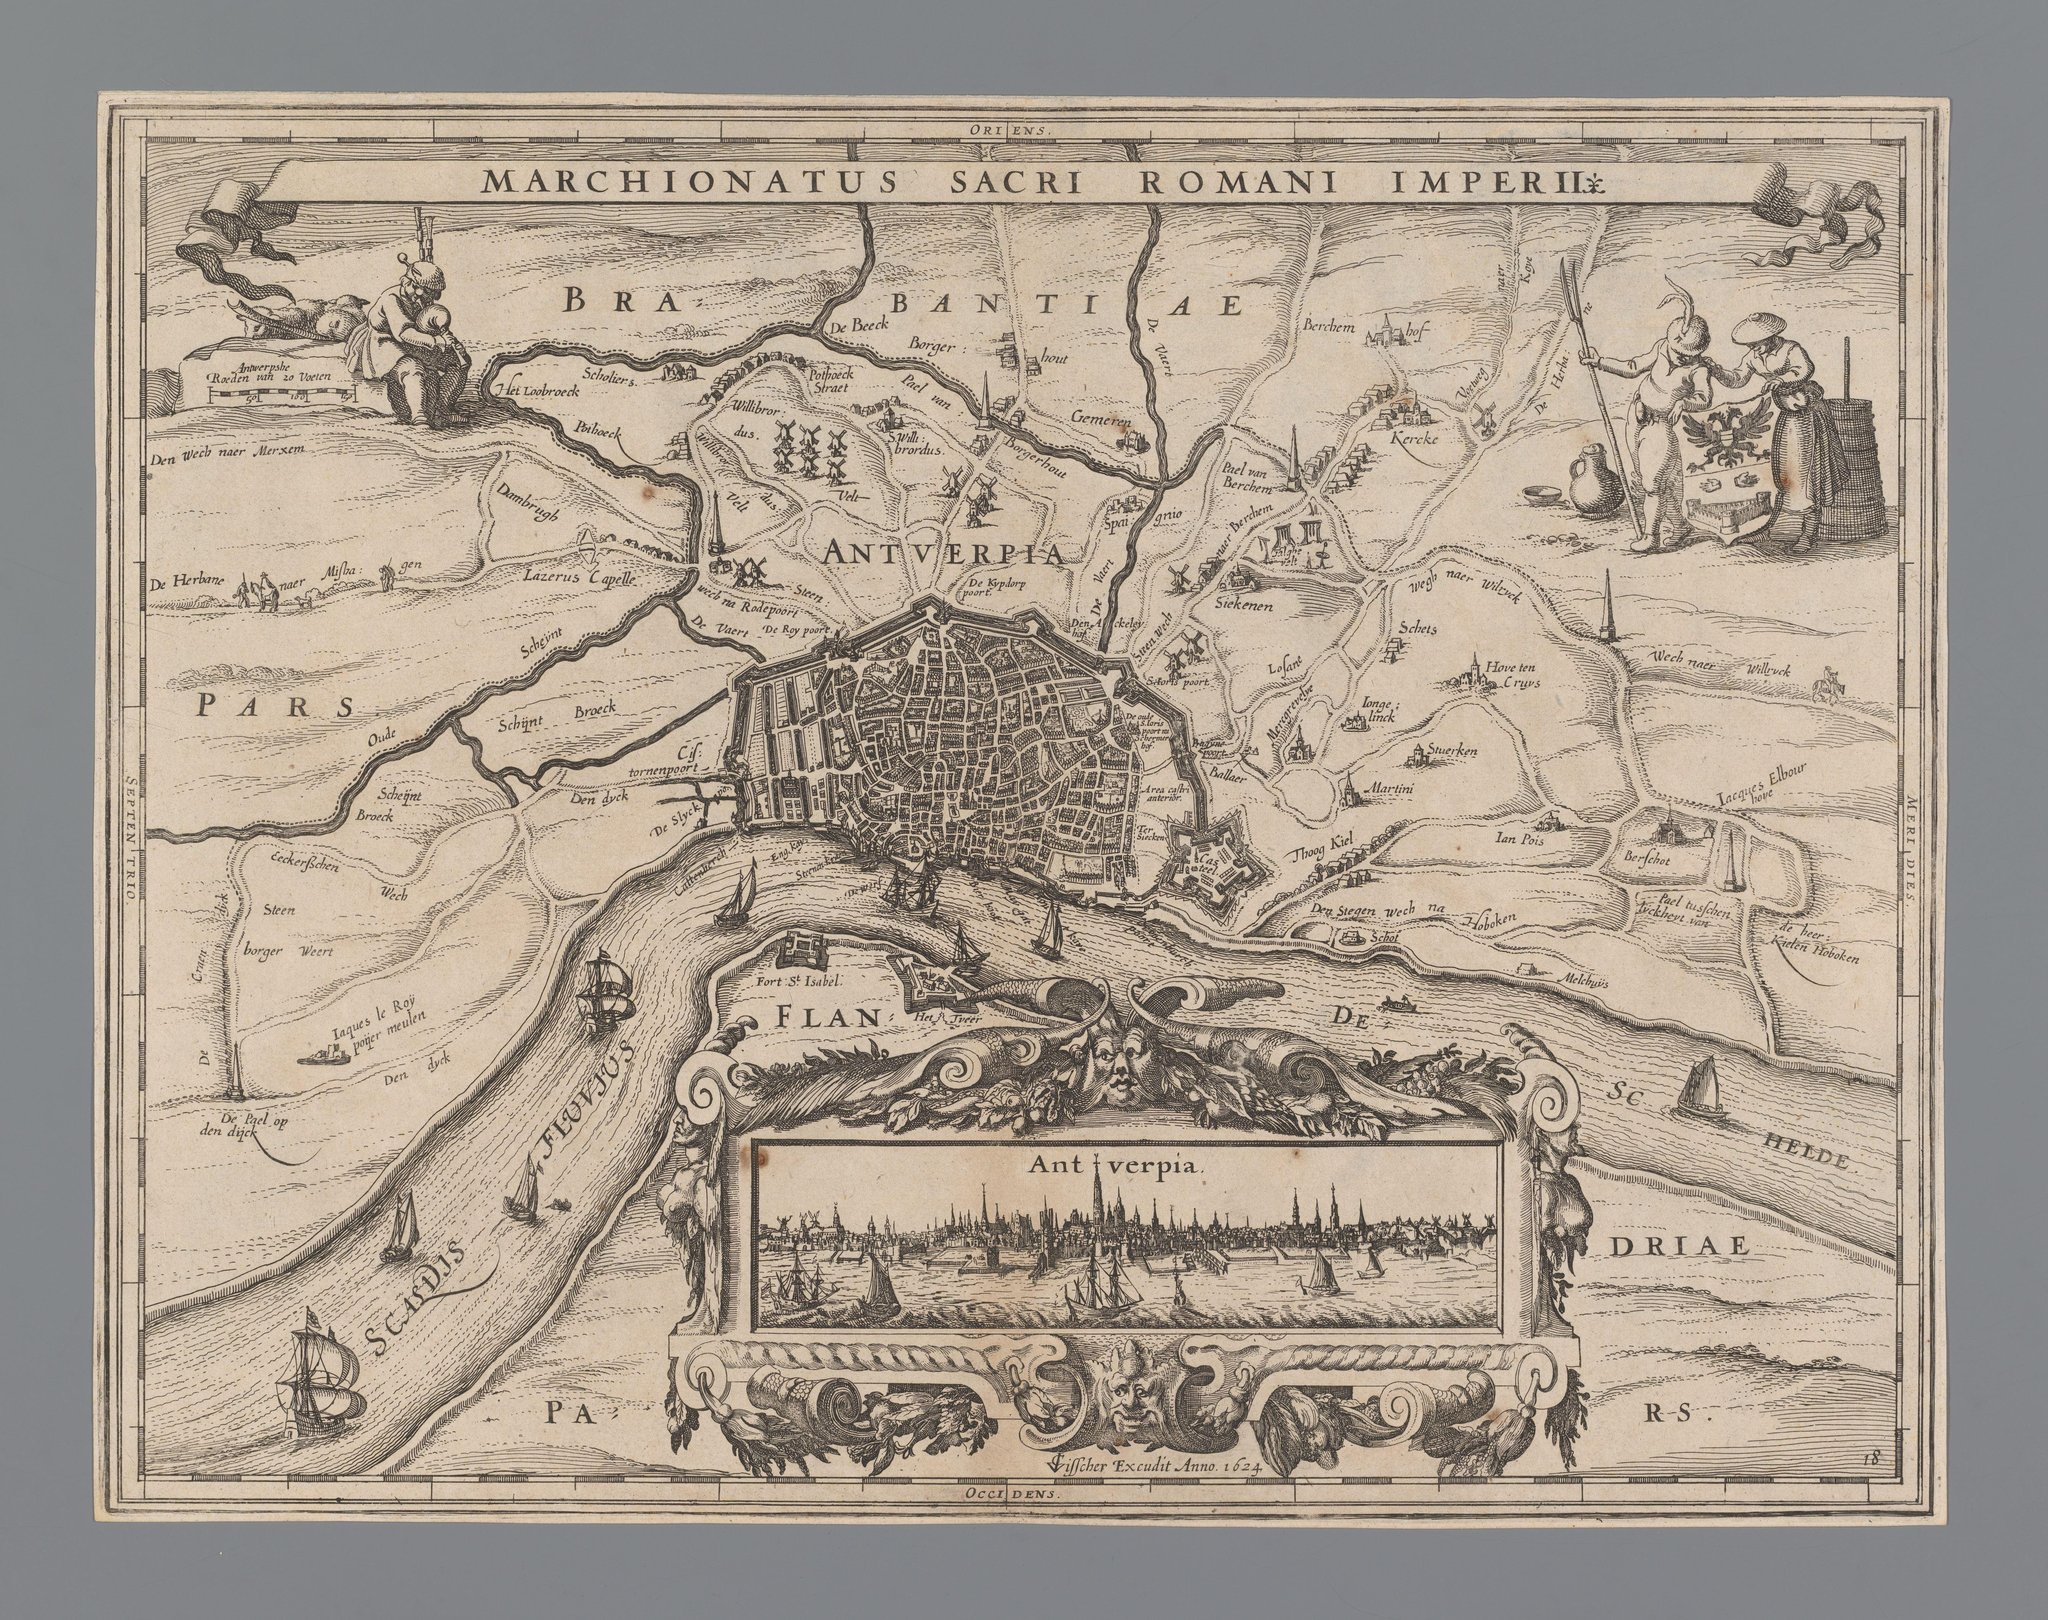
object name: print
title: Plattegrond van Antwerpen met stadsgezicht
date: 1624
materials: paper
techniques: engraving, etching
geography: amsterdam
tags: coat of arms (as symbol of the state, etc.) (+ city; municipal), bagpipe, musette, farmers, maps of cities, prospect of city, town panorama, silhouette of city, antwerp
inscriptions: date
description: Plattegrond van Antwerpen. Boven in een banderol de titel. Onder een gezicht op Antwerpen vanaf de Schelde. Linksboven een doedelzakspeler met daarnaast een schaalstok: 200 Antwerpshe Roeden van 20 Voeten. Rechtsboven twee boeren die het wapen van Antwerpen vasthouden.